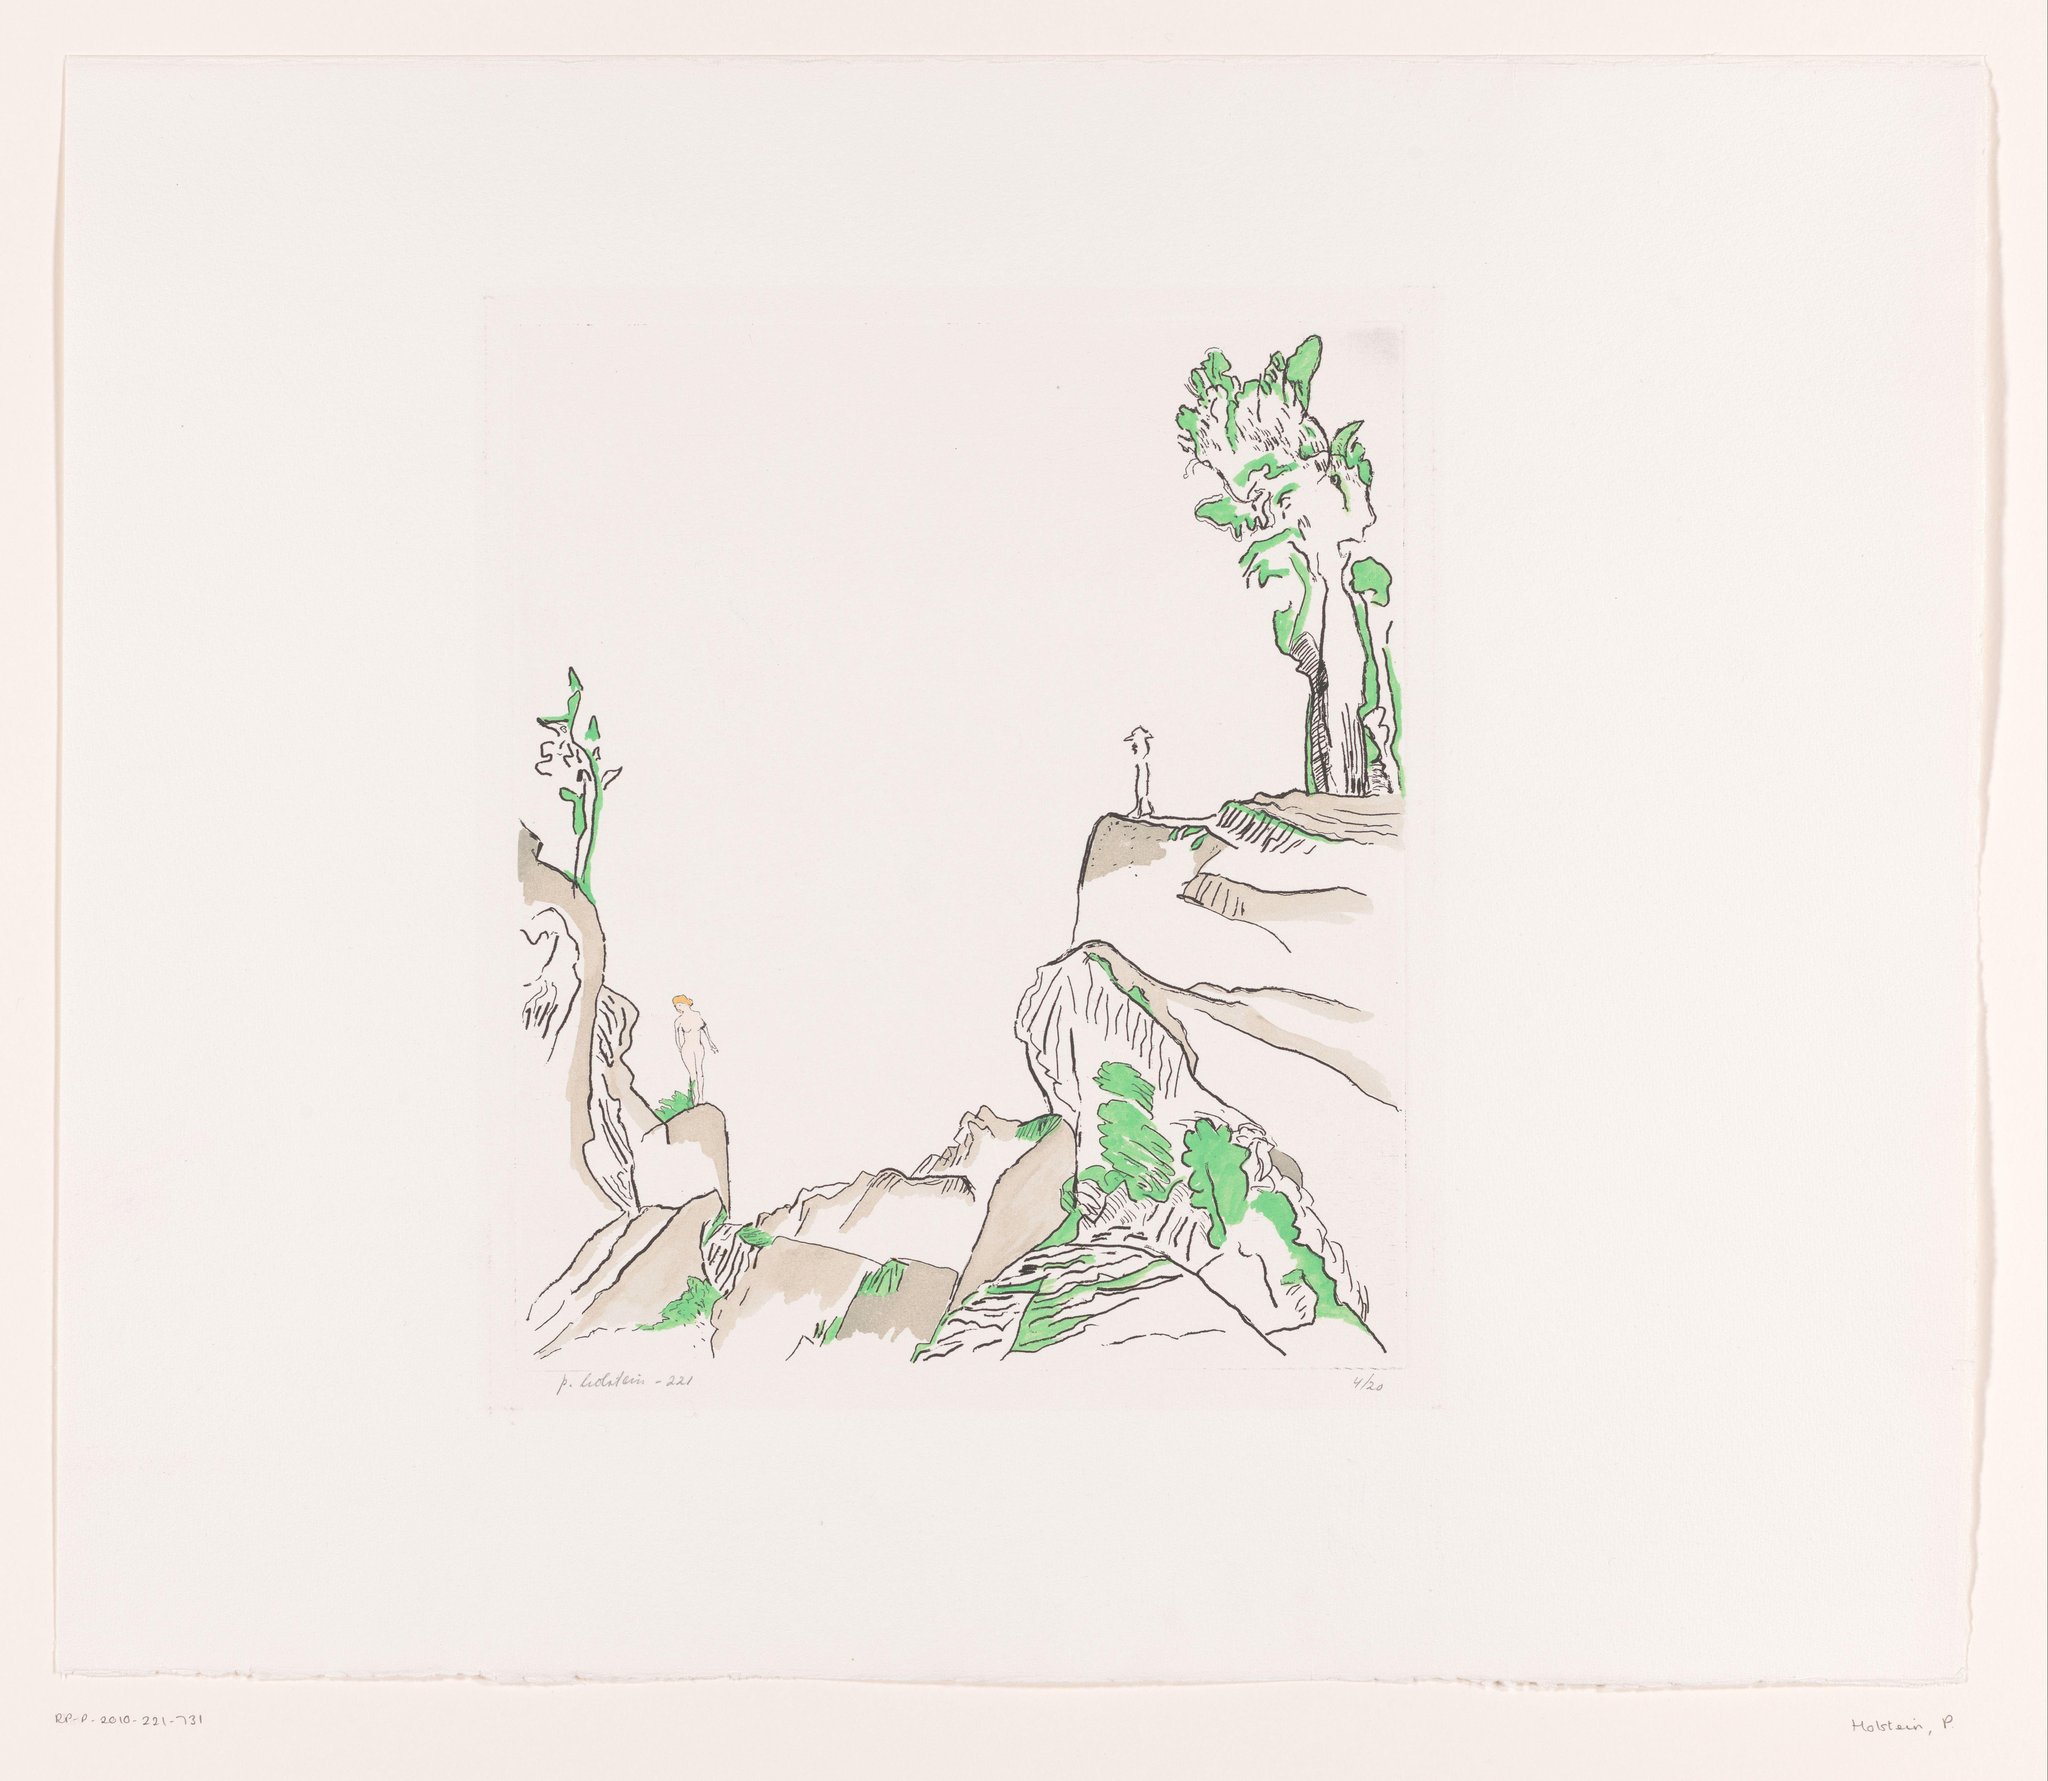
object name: print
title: Titel onbekend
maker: pieter holstein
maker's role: draughtsman, painter, print maker, sculptor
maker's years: 1934-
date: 1975-1980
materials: paper, watercolor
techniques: brush, etching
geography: amsterdam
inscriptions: signature: ‘p. holstein - 221’, edition: ‘4/20’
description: De huidige titels zijn door het museum toegekend bij gebrek aan informatie over een originele titel.